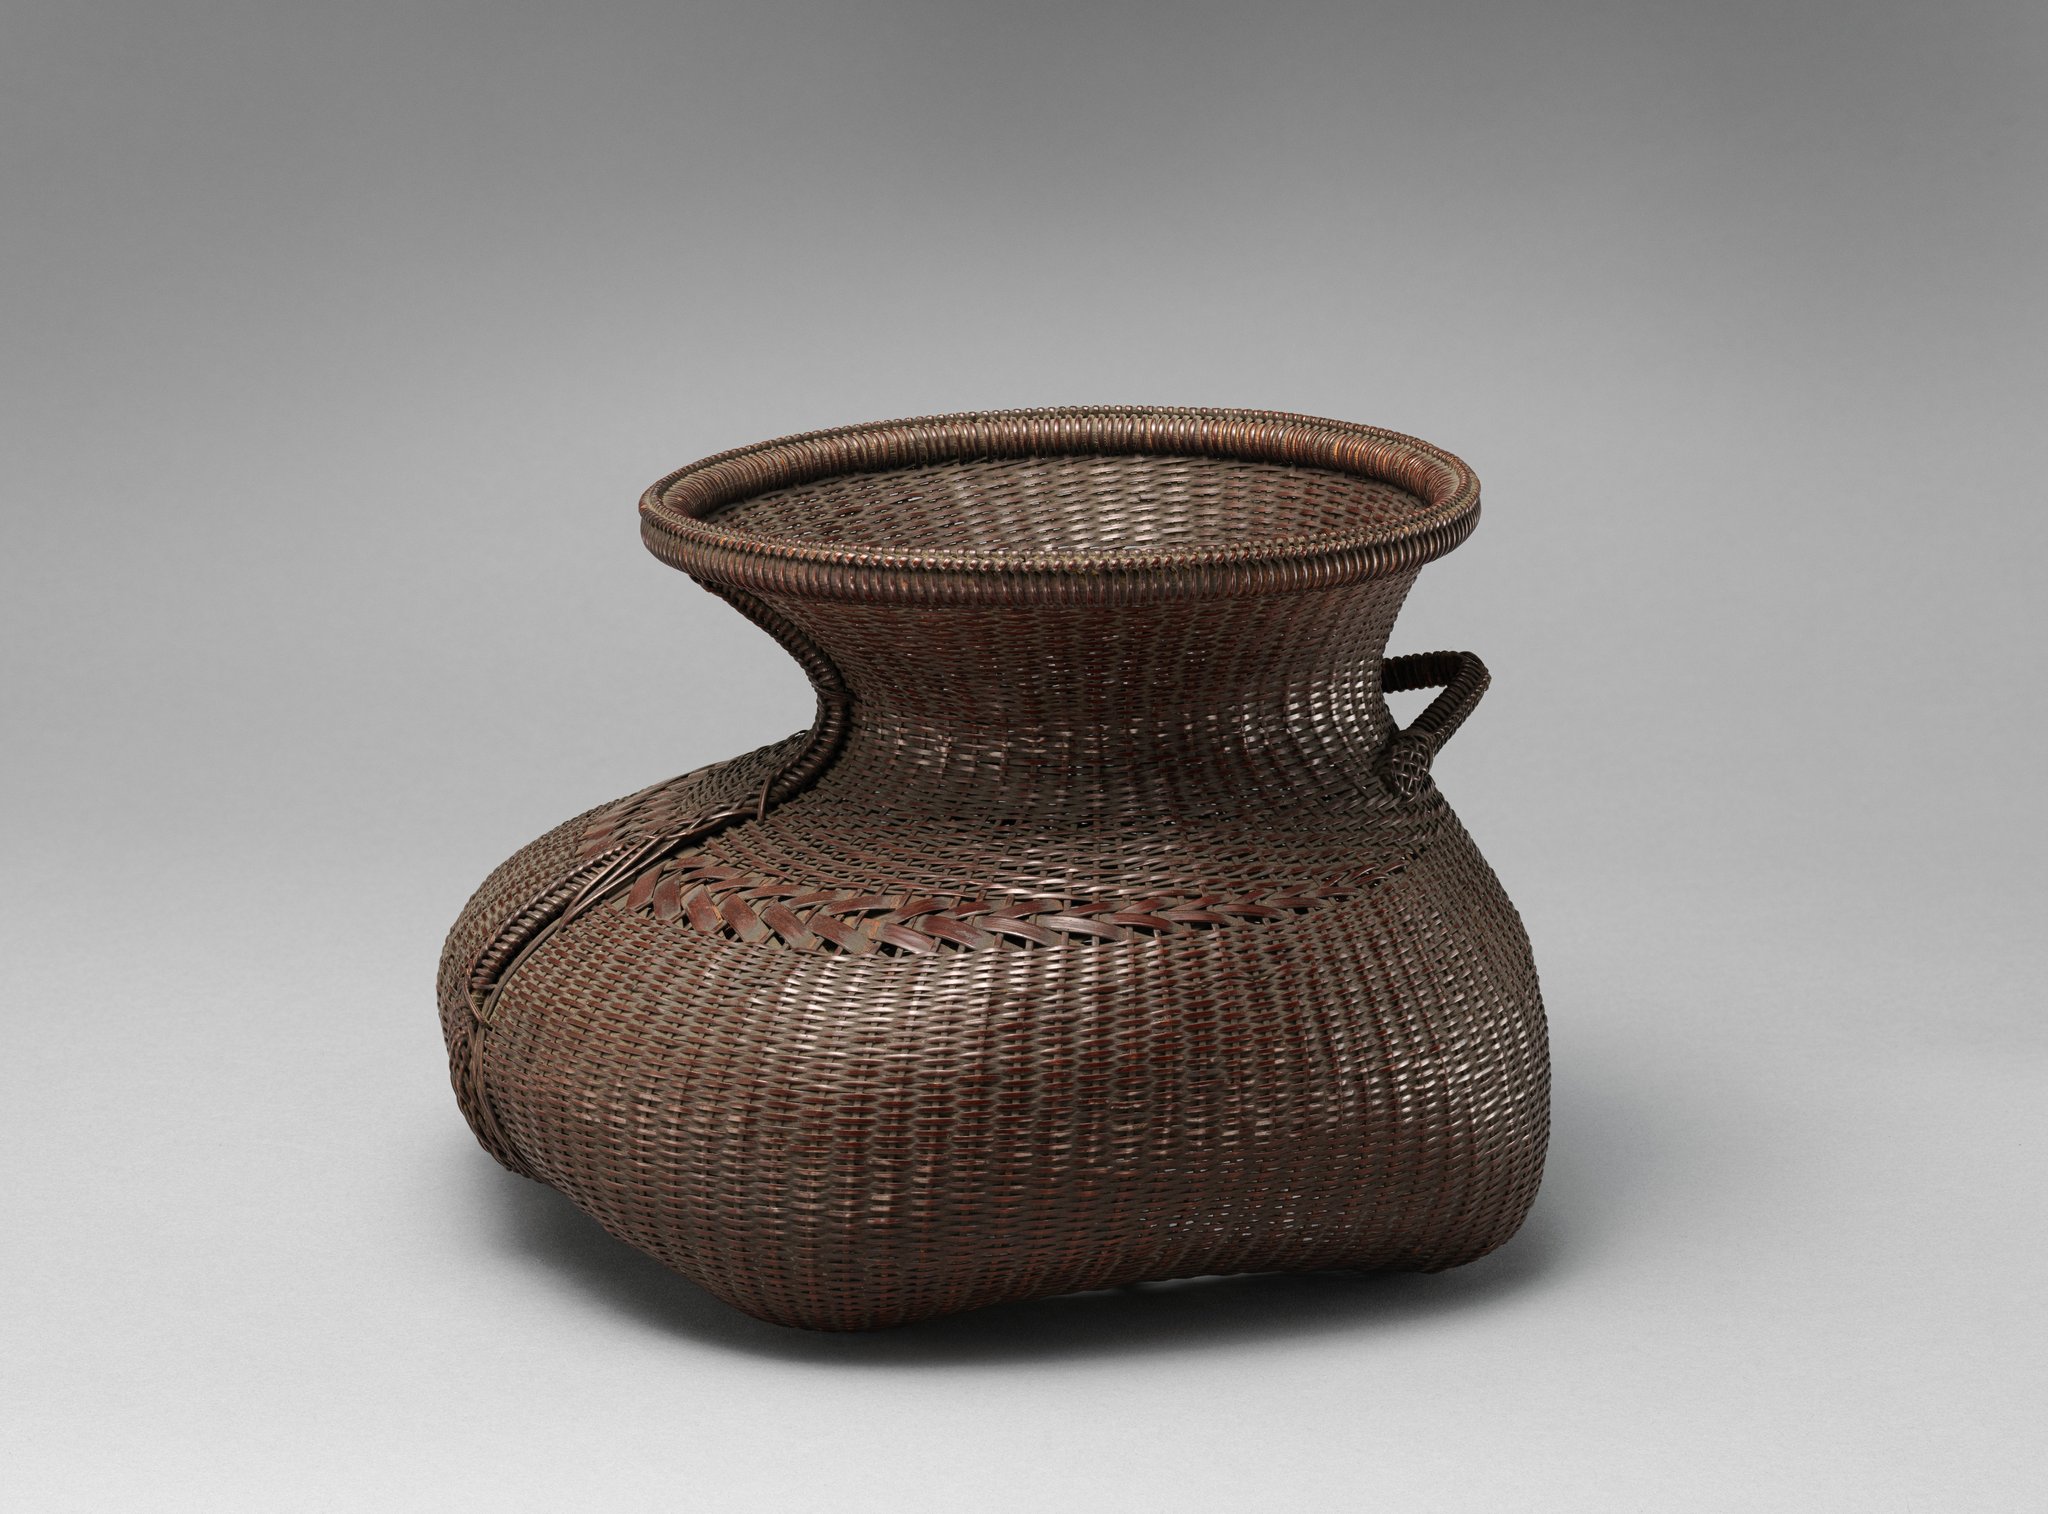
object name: basket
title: Fishing-Style Basket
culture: japanese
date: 1801-1900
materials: bamboo, lacquer